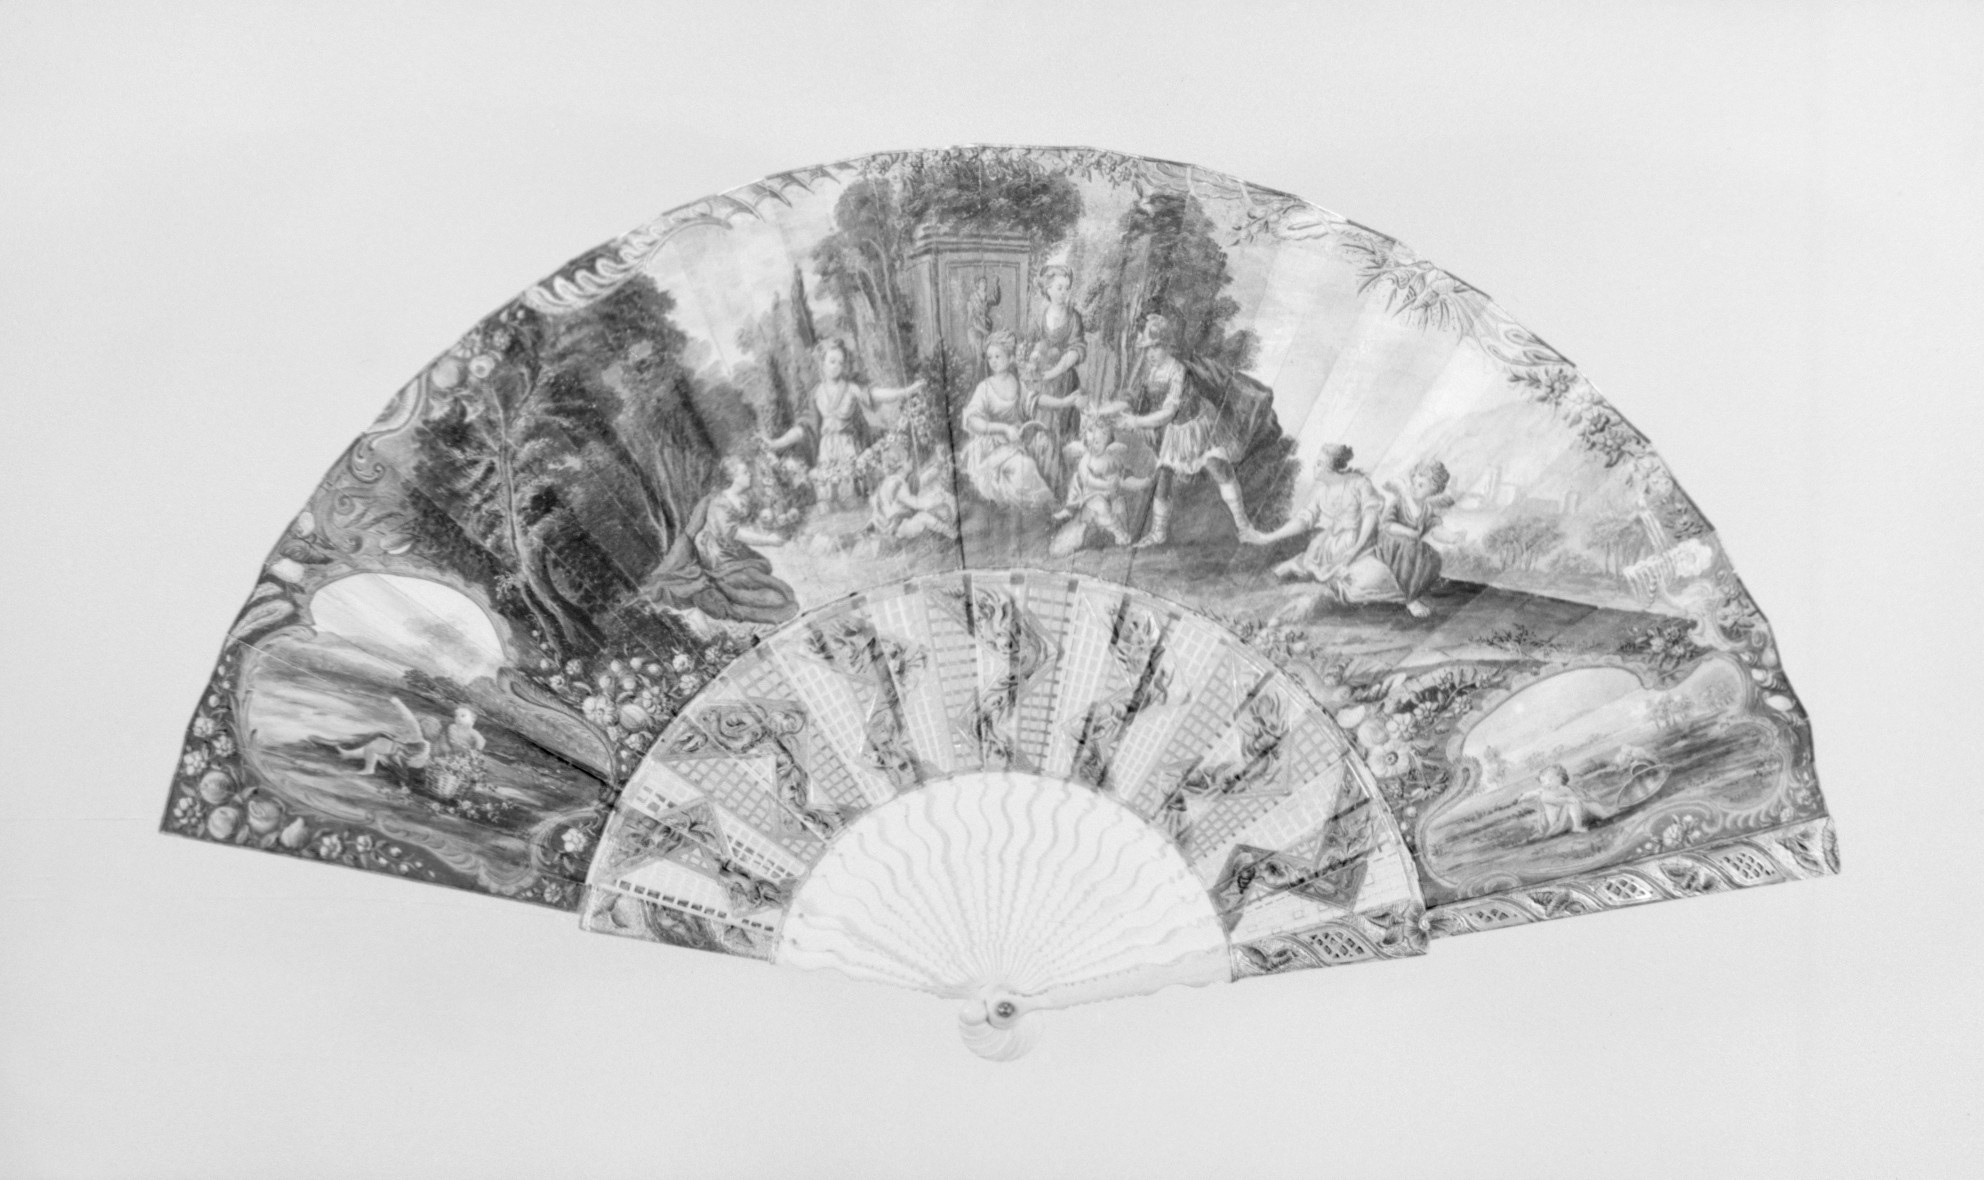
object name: fan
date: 1701-1800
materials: ivory, mother of pearl, paper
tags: men,women,cupid